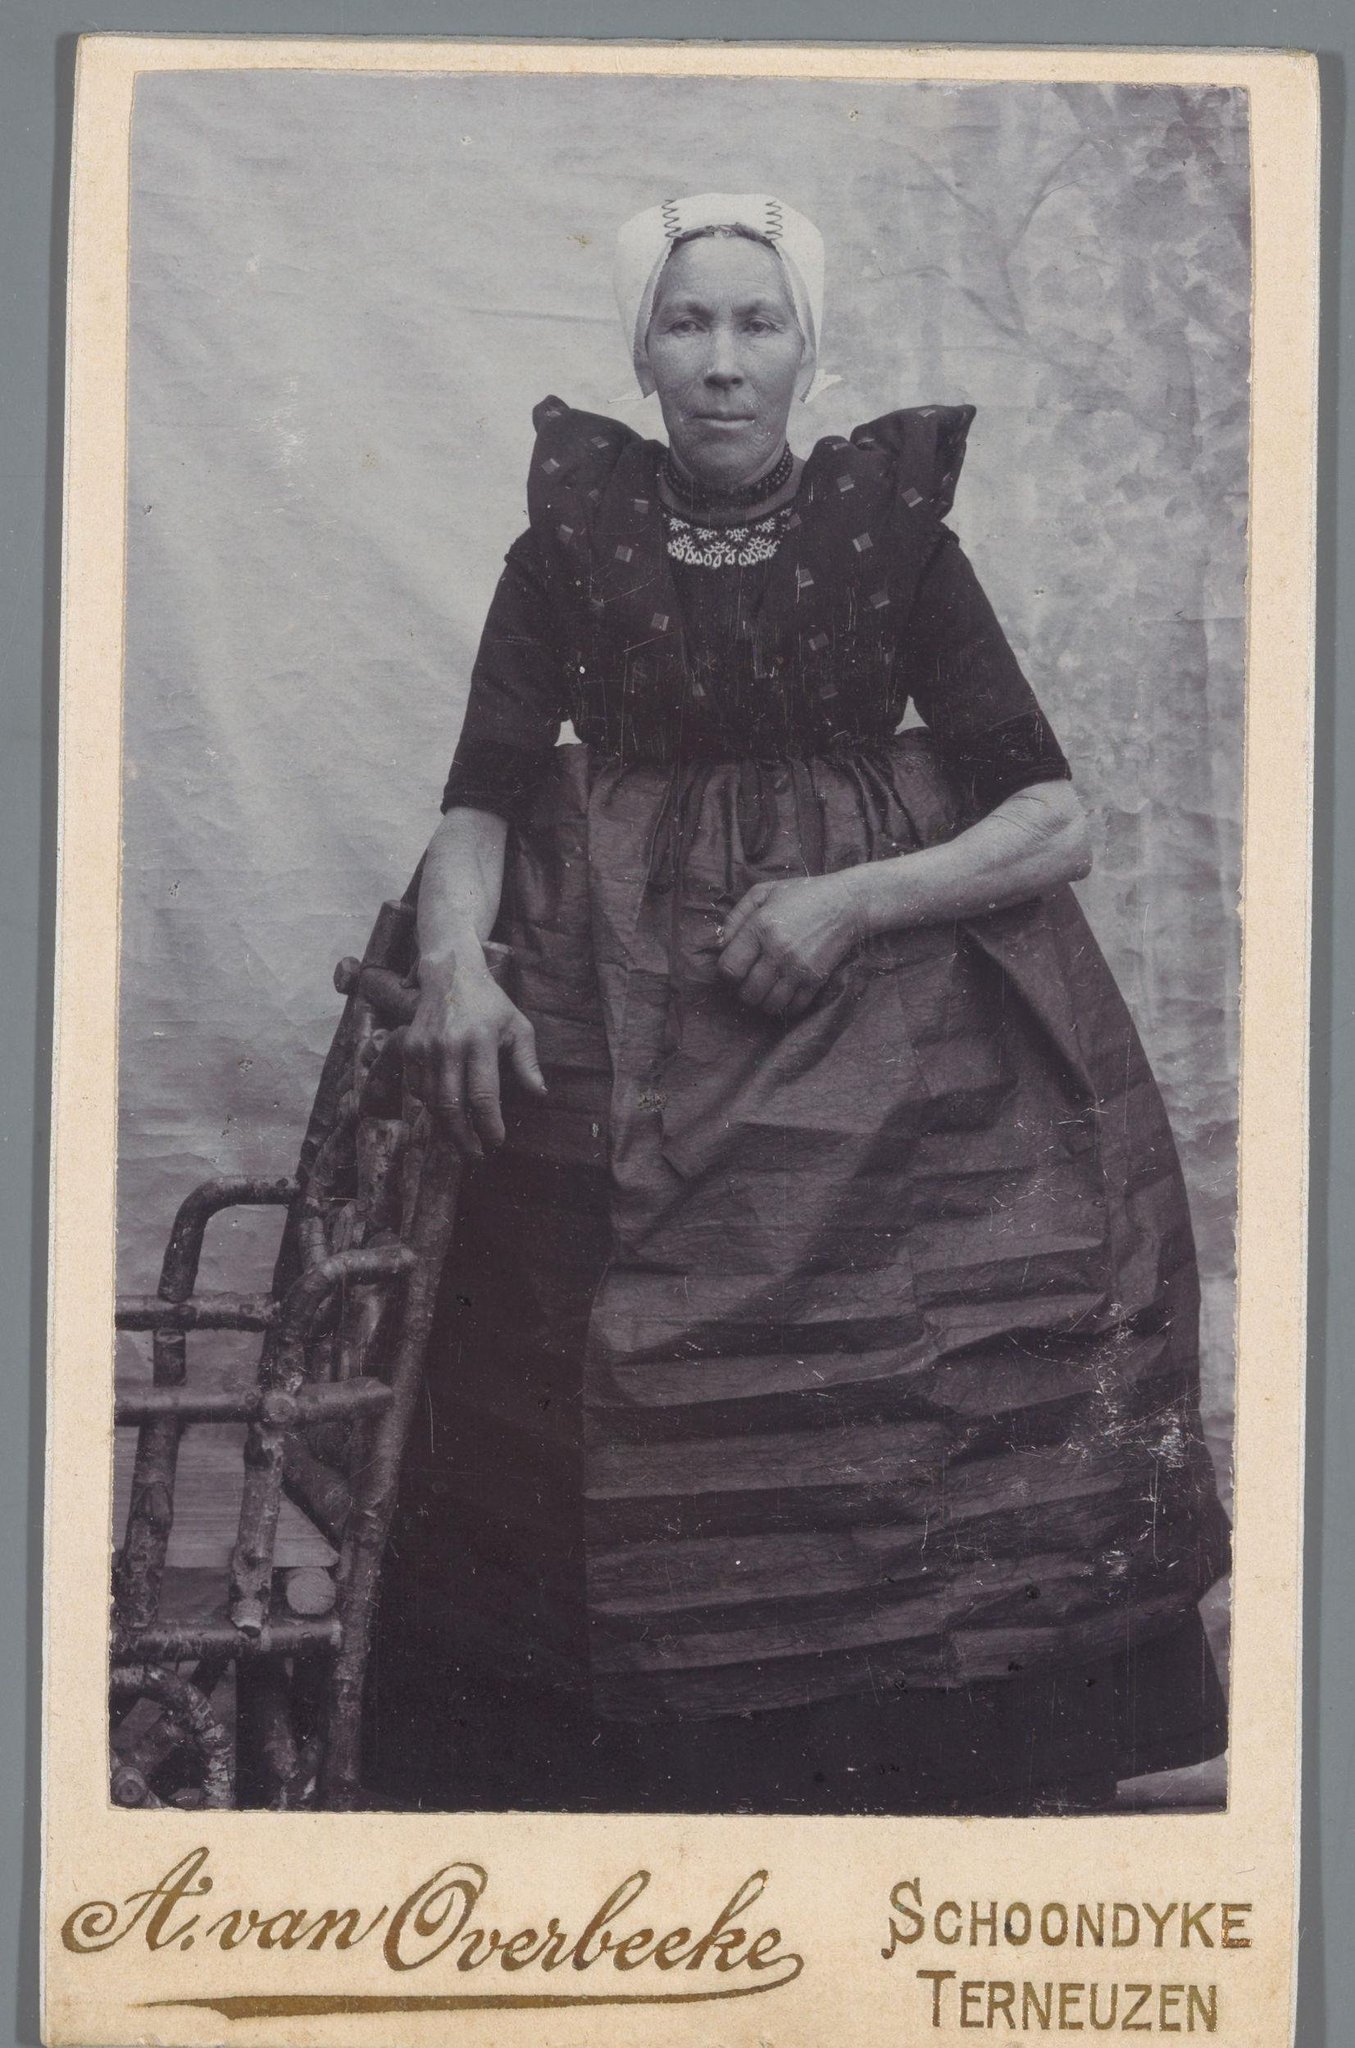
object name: photograph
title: Portret van een onbekende vrouw in Zeeuwse klederdracht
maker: abraham van overbeeke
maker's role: publisher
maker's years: 1836-1914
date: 1890-1914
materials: paper, cardboard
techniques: collodion silver print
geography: terneuzen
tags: adult woman, anonymous historical person portrayed, folk costume, regional costume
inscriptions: address: ‘SCHOONDYKE/ Markt./ TERNEUZEN/ Donze-Visserstraat.’, inscription: ‘Deplaat blyft voor nabestelling bewaard./ Vergrootingen naar ieder beeld.’